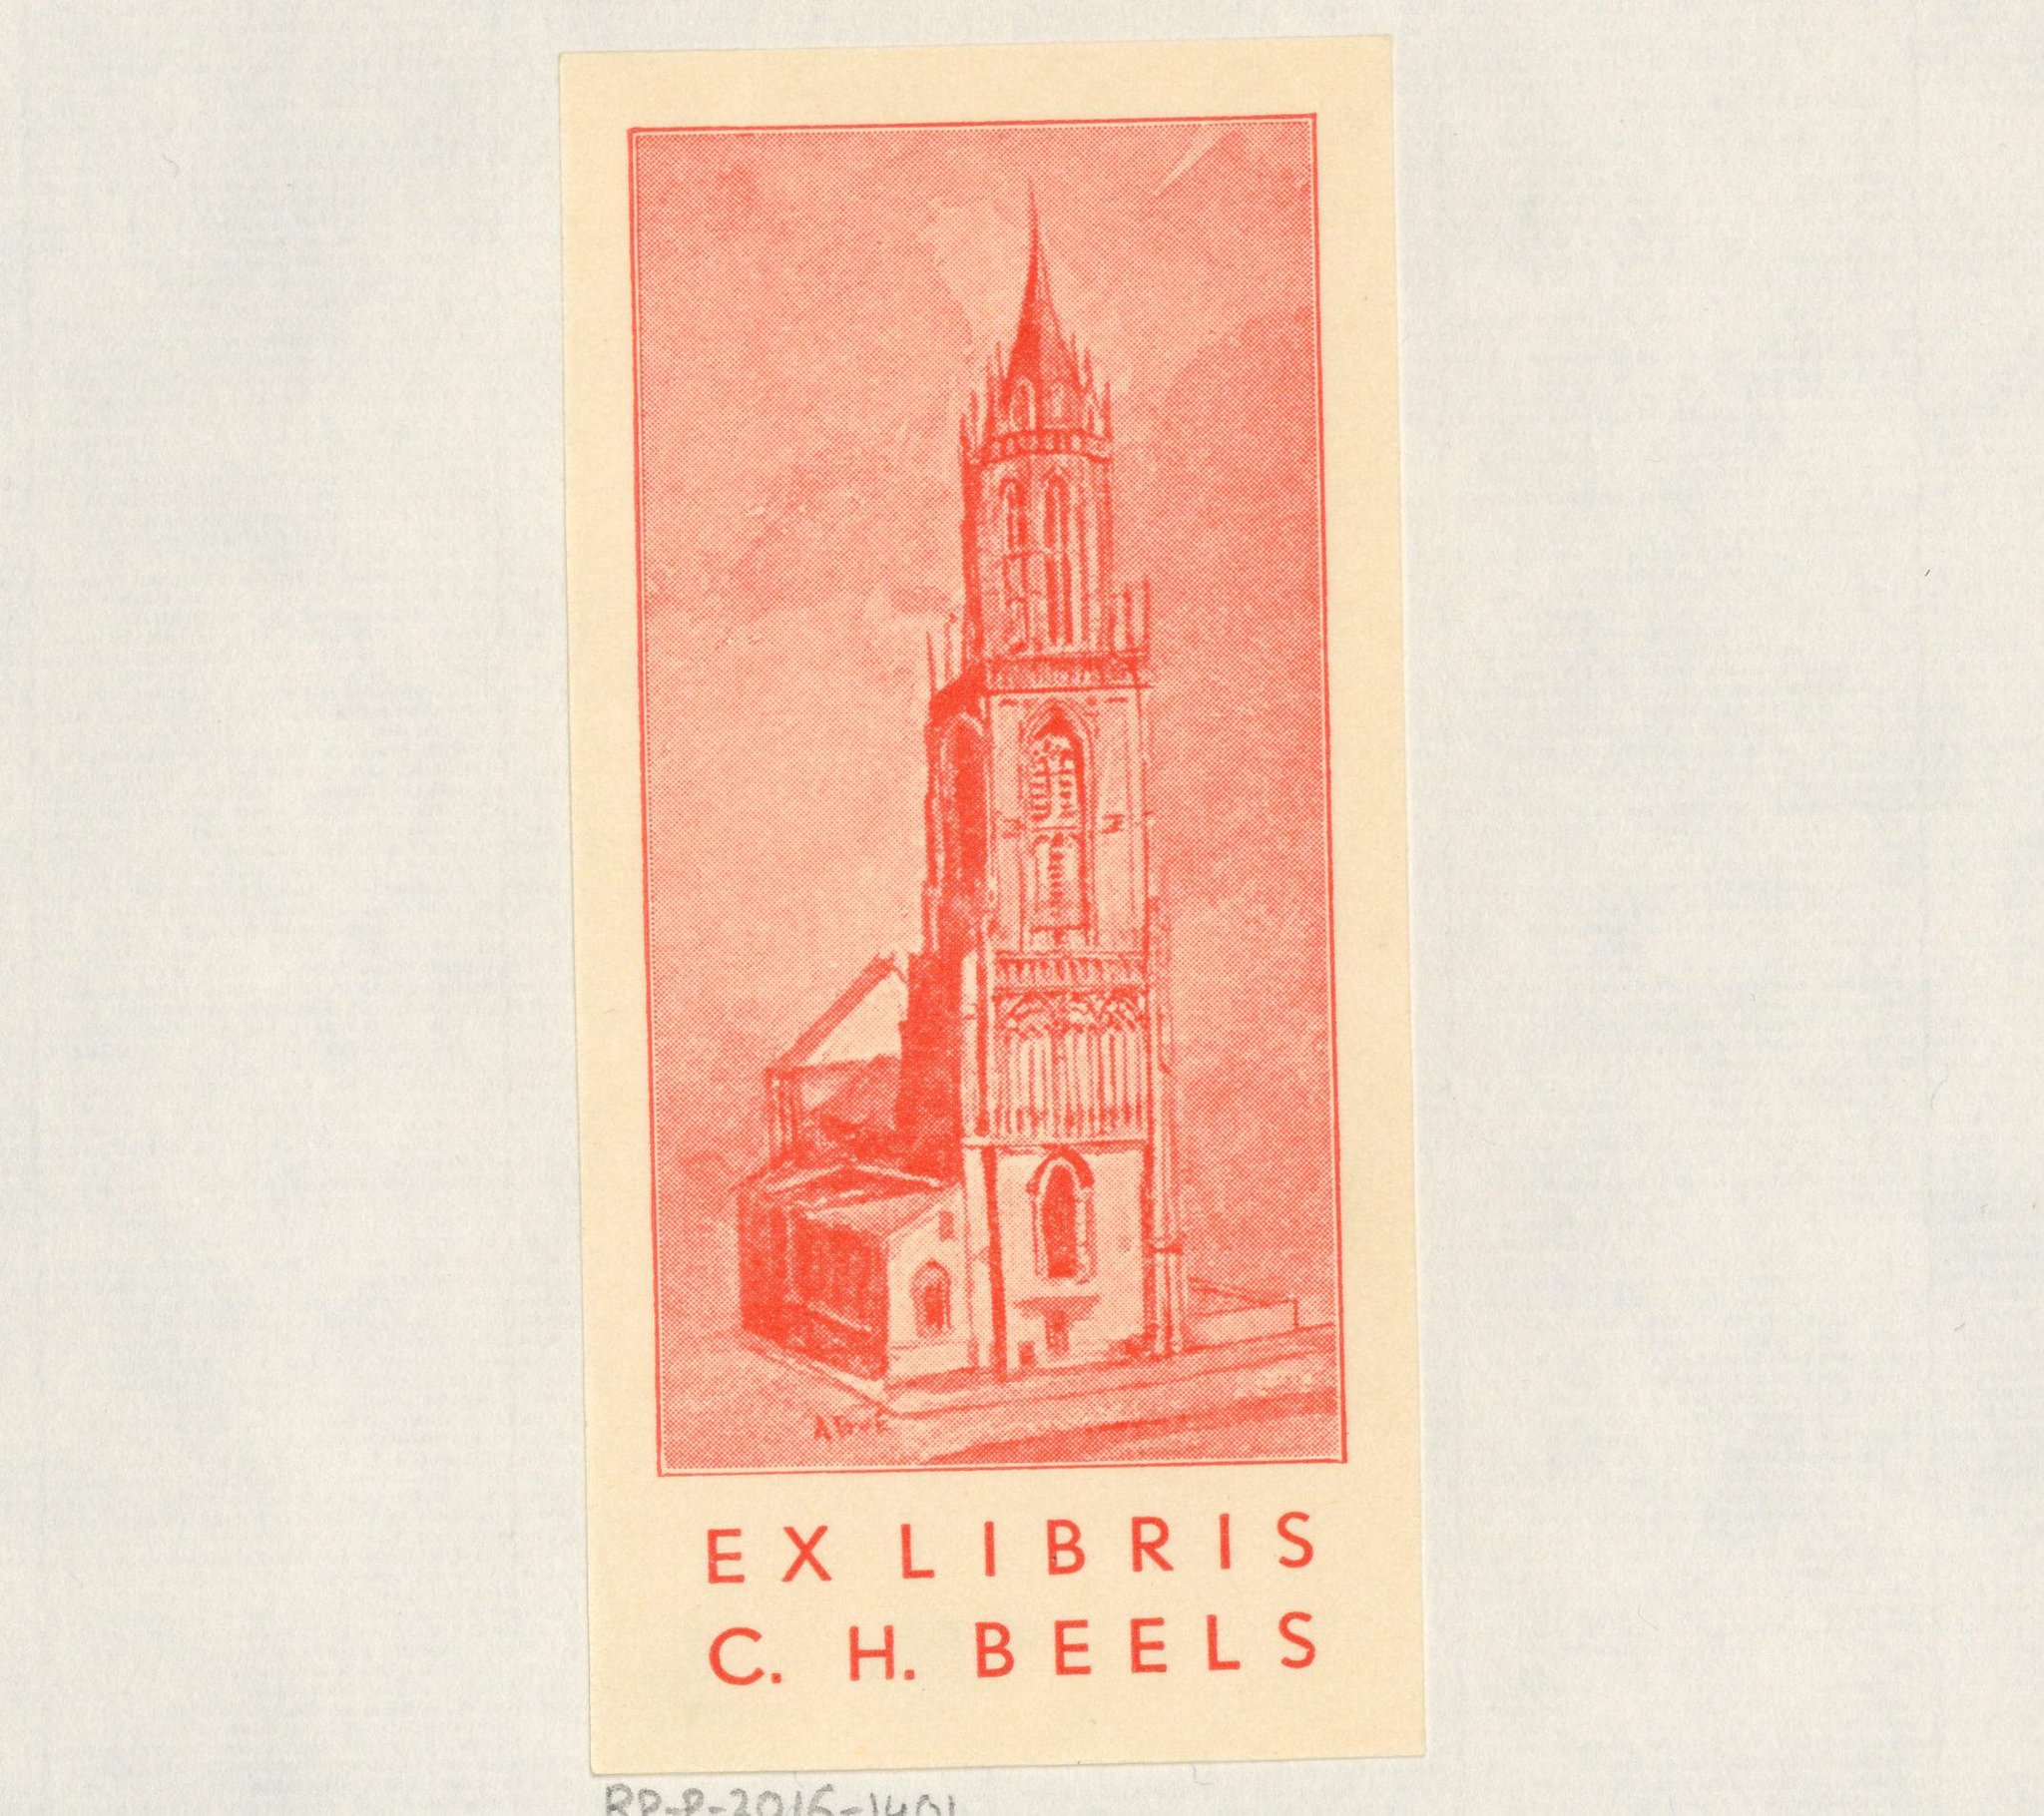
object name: bookplate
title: Ex libris van C.H. Beels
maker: Anonymous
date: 1920-1970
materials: paper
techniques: autotype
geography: netherlands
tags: clemens haro beels, church (exterior)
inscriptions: inscription: ‘2584 / 2’